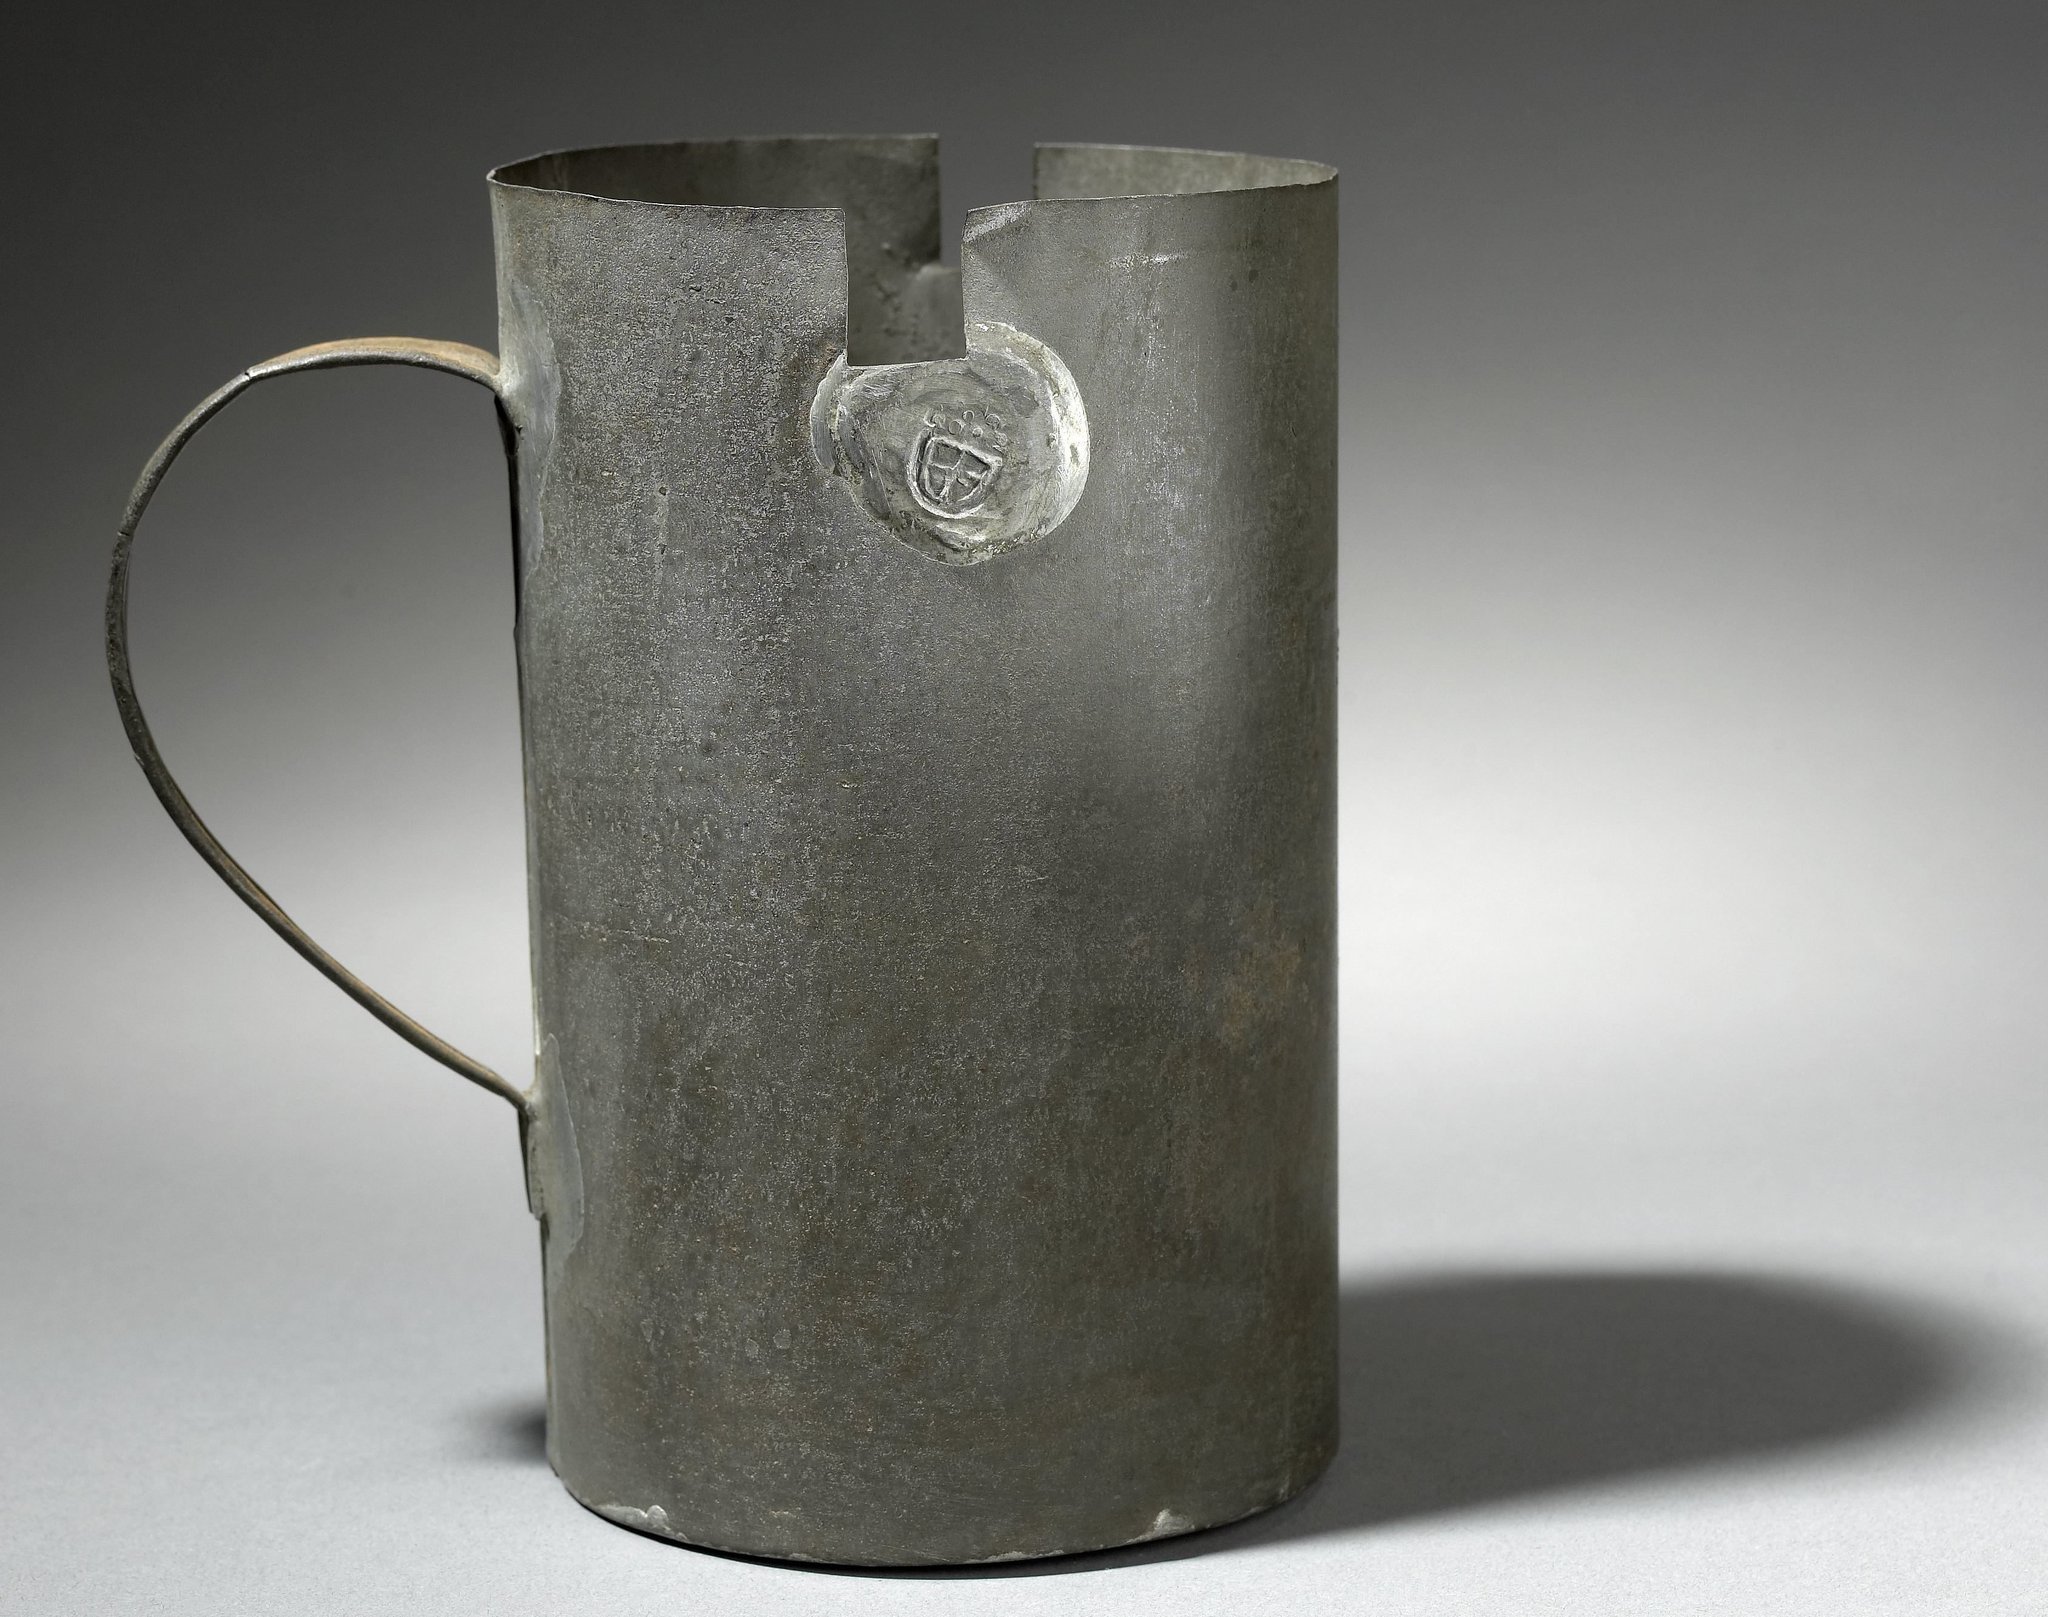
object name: inhoudsmaat natte waren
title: Maat van ca. 0,757 liter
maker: Anonymous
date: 1800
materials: metal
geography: netherlands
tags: netherlands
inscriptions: mark